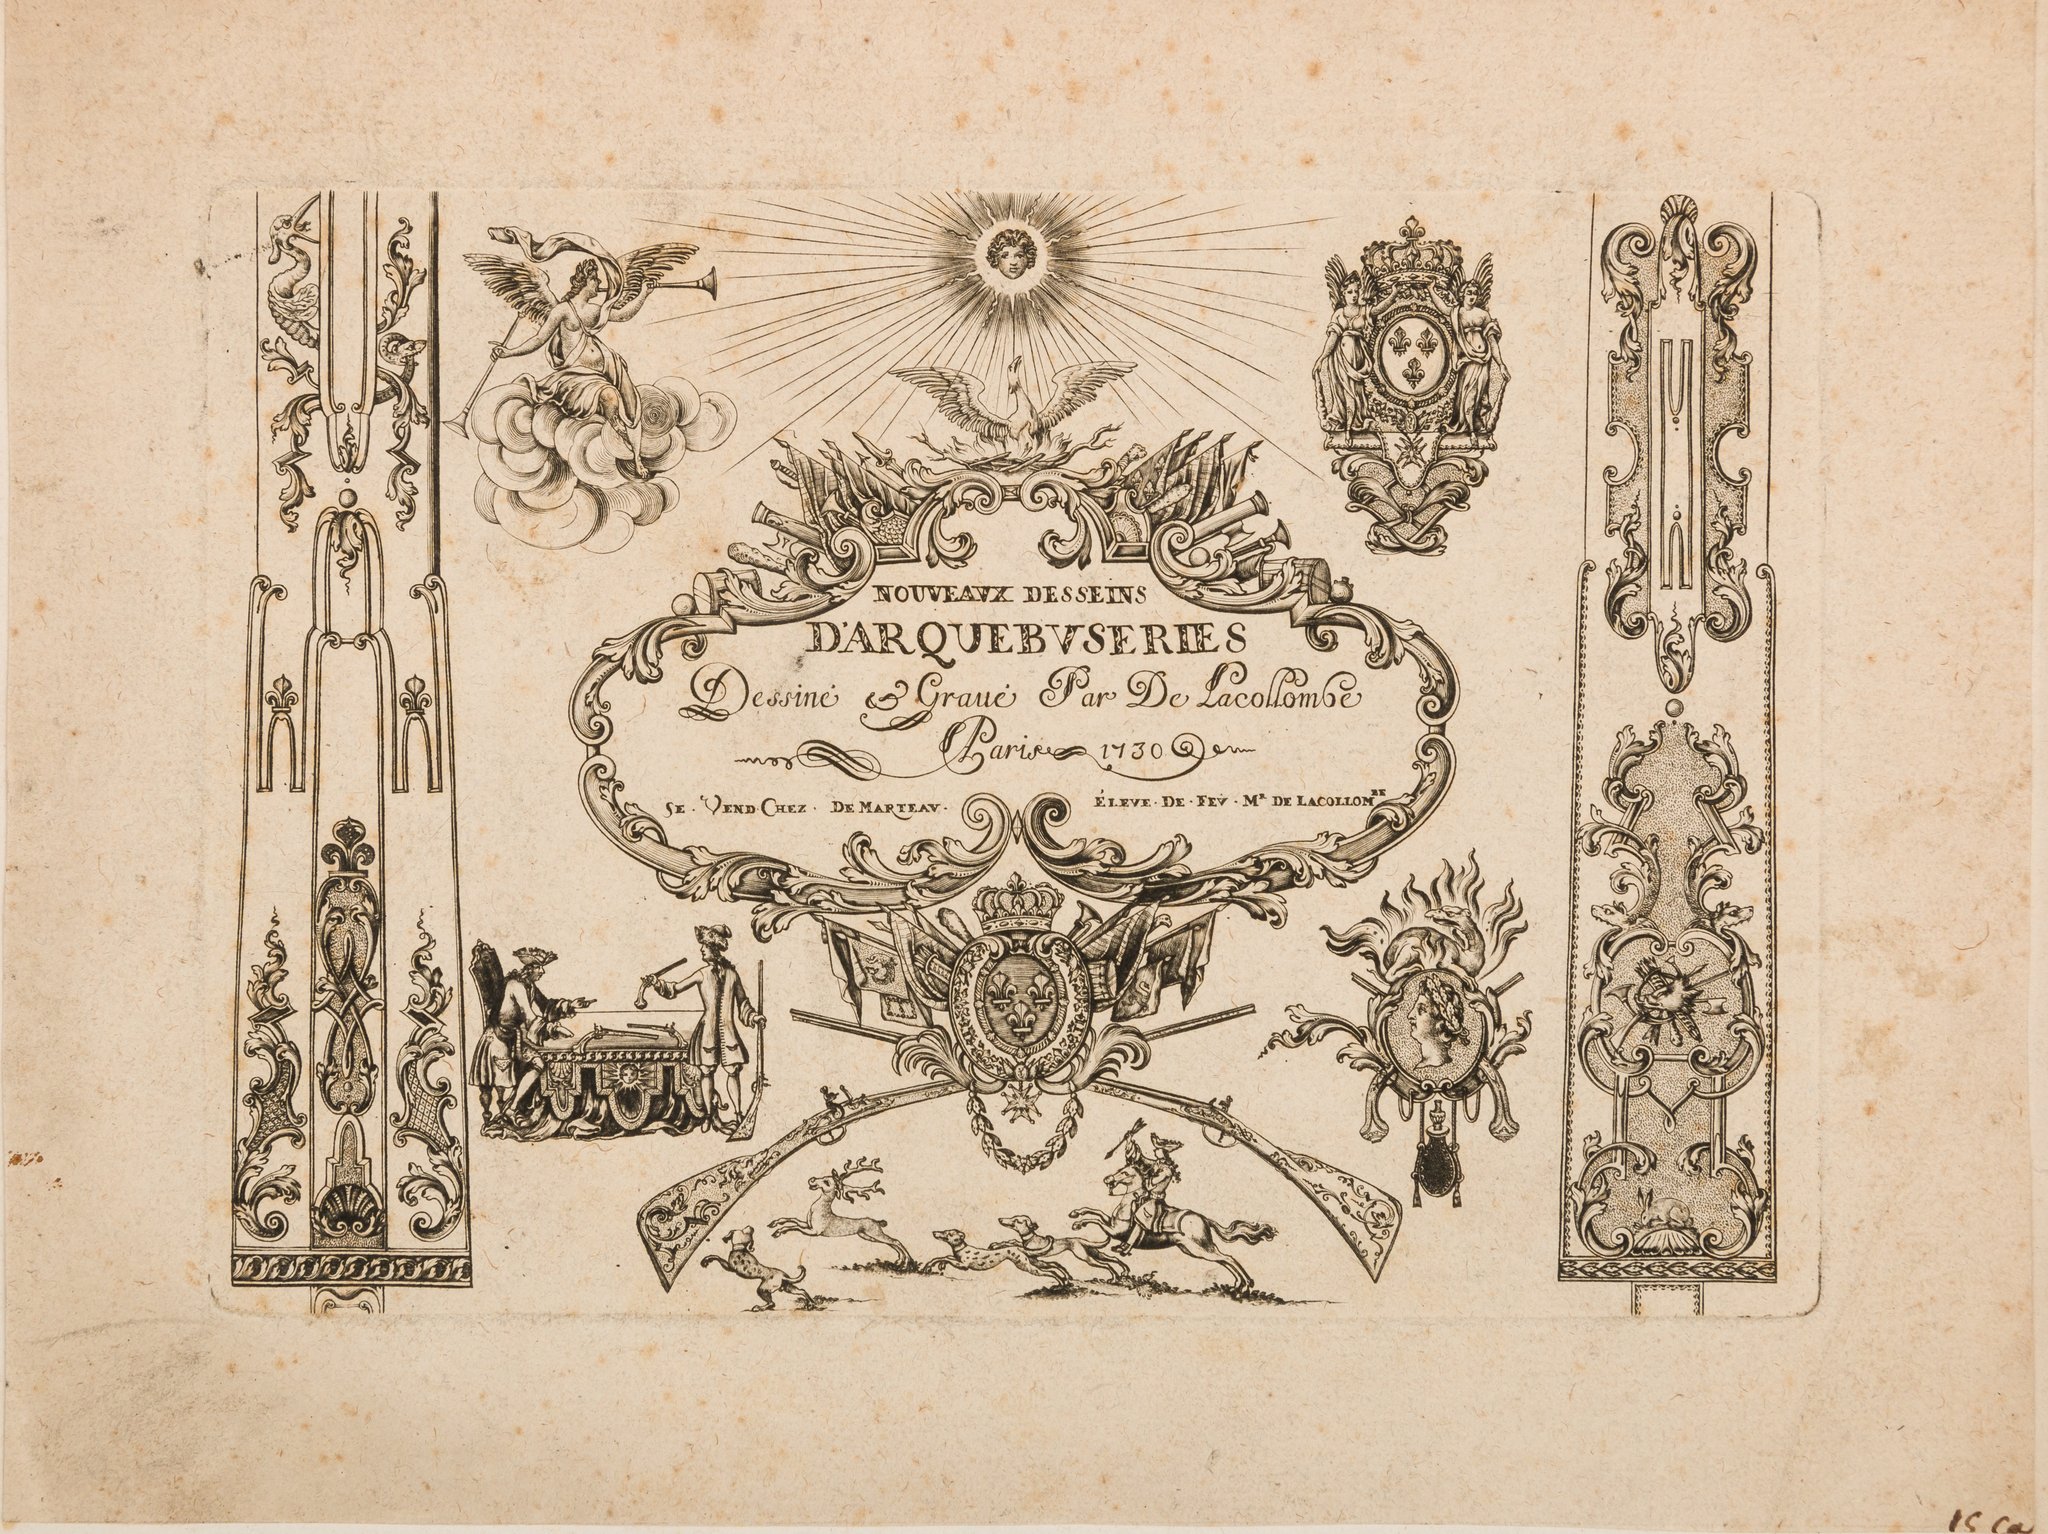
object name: engraving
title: Nouveavx Desseins D'Arquebvseries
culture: french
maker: de lacollombe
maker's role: engraver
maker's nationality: french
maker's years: 1702-1736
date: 1705-1749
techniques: engraving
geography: france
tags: firearms,ornament